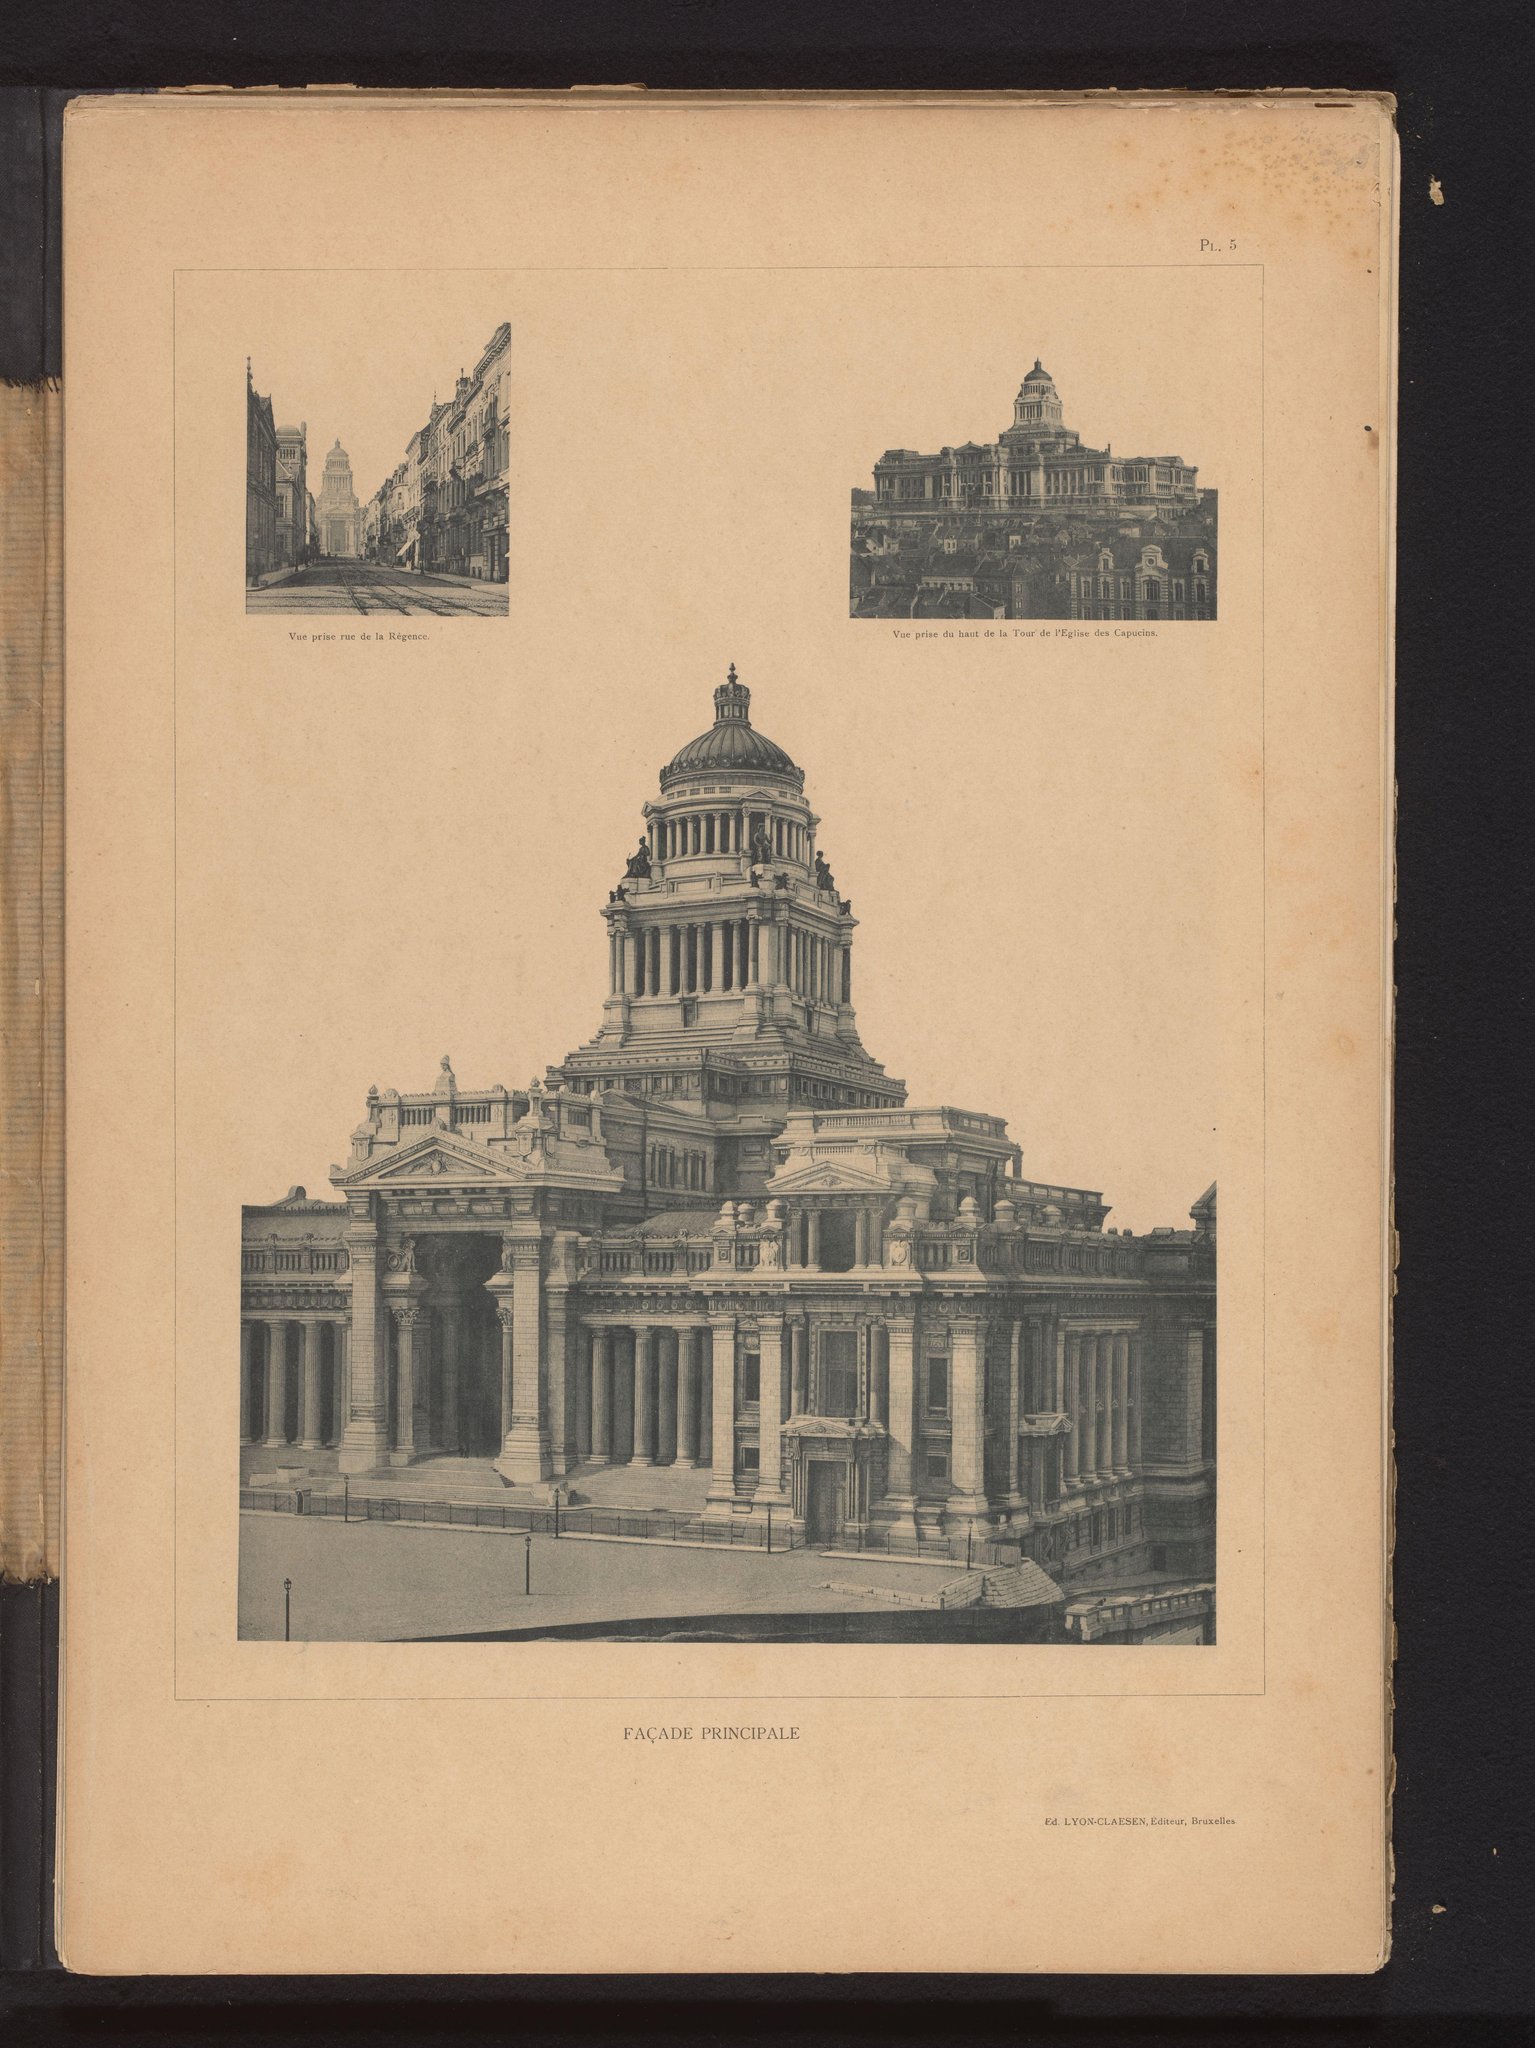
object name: photomechanical print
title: Façade Principale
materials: paper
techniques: photograph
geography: brussels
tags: court building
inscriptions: number: ‘PL. 5’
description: Deze prenten maken deel uit van een omslag met 30 prenten op 28 bladen en een titelblad.